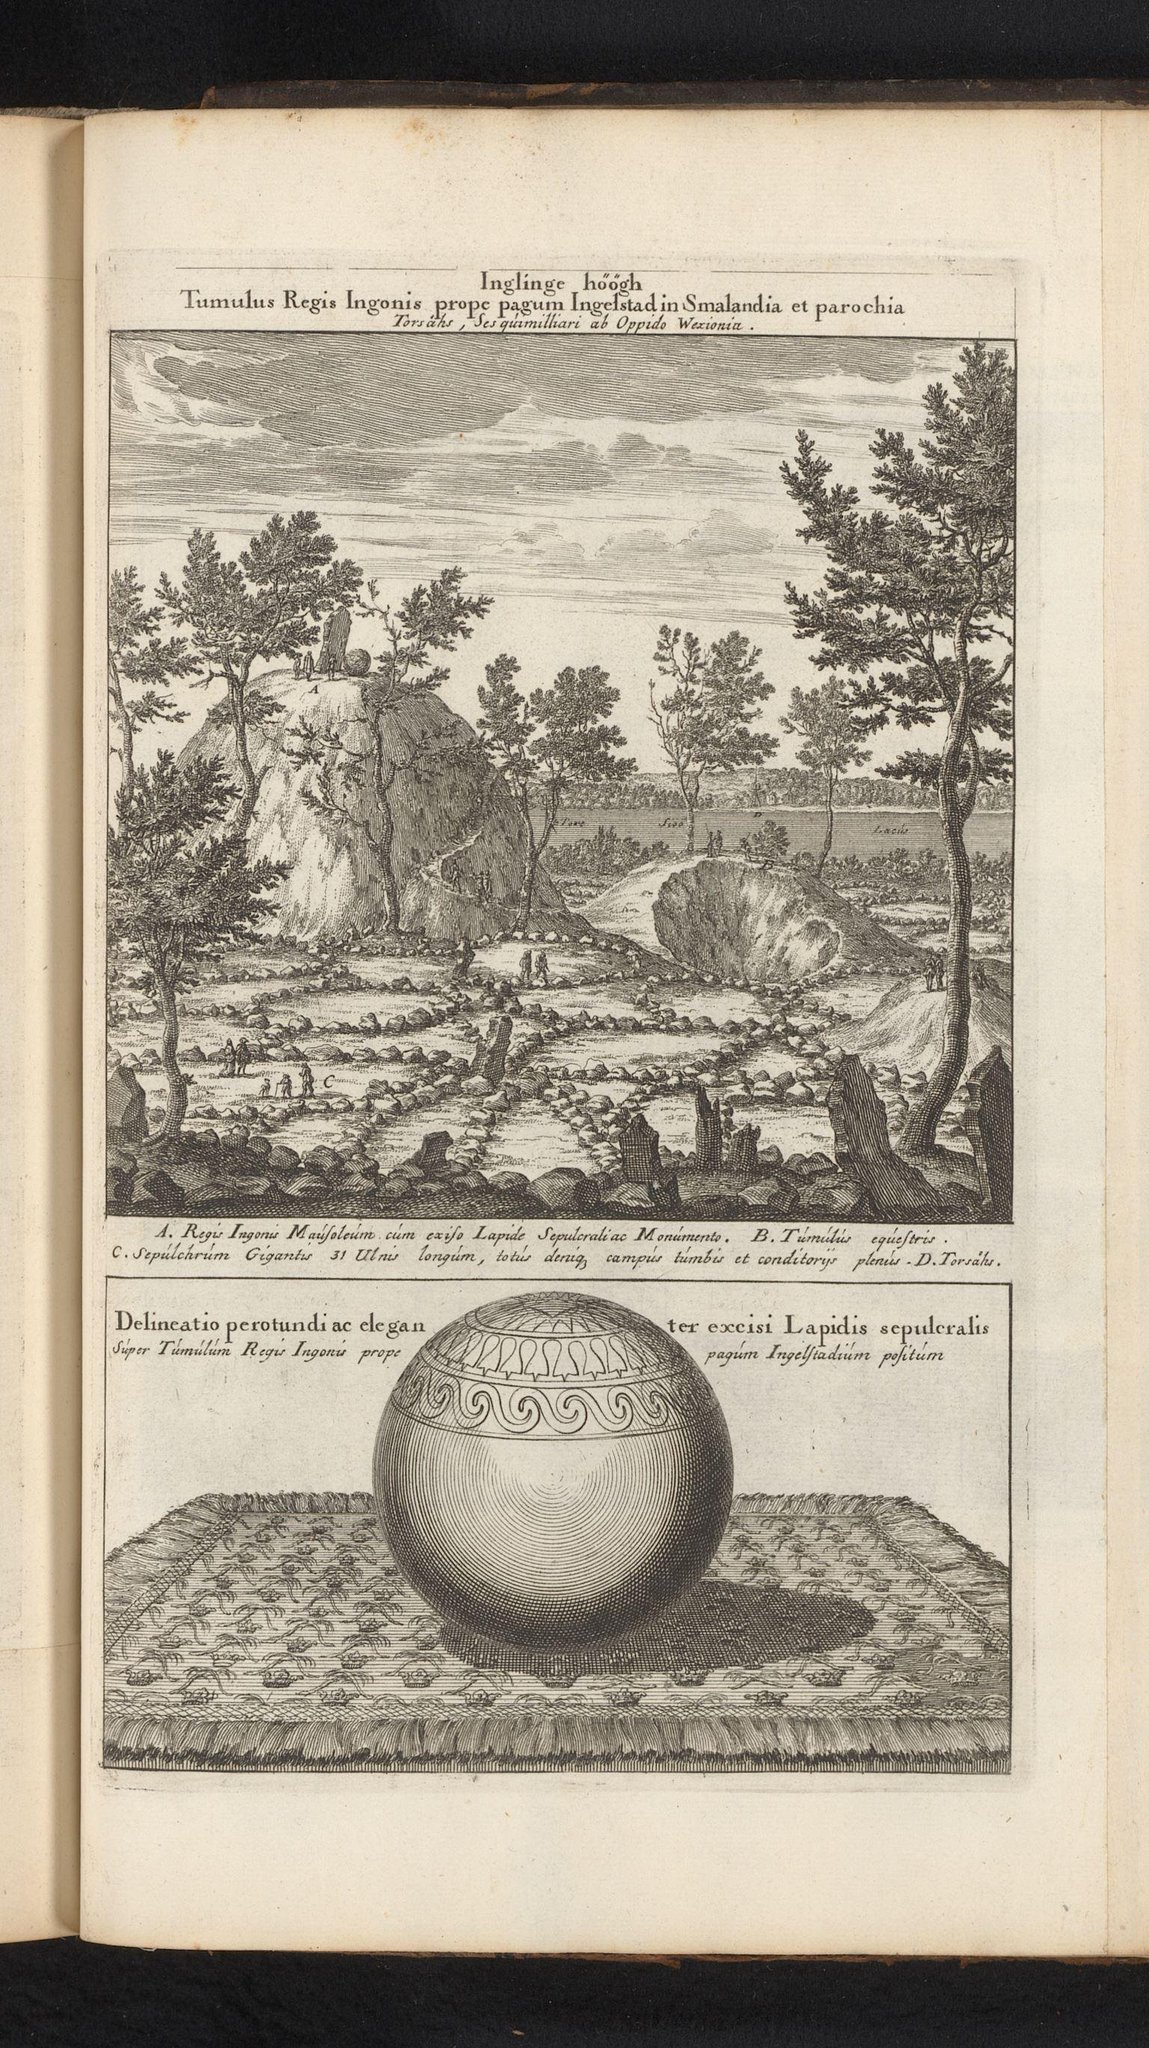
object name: album leaf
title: Inglinge höögh. Tumulus Regis Ingonis prope pagum Ingelstad in Smalandia et parochia Torsåhs, Sesquimilliari ab Oppido Wexionia / Delineato perotundi ac eleganter excisi Lapidis sepulcralis Super Tumulum Regis Ingonis prope pagum Ingelstadium positum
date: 1693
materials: paper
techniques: etching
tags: grave, tomb and other grave-forms and grave-markers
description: Kungliga Biblioteket, 'Suecia': http://www.kb.se/samlingarna/Kartor-bilder/Suecia-antiqua/ (geraadpleegd november 2016).